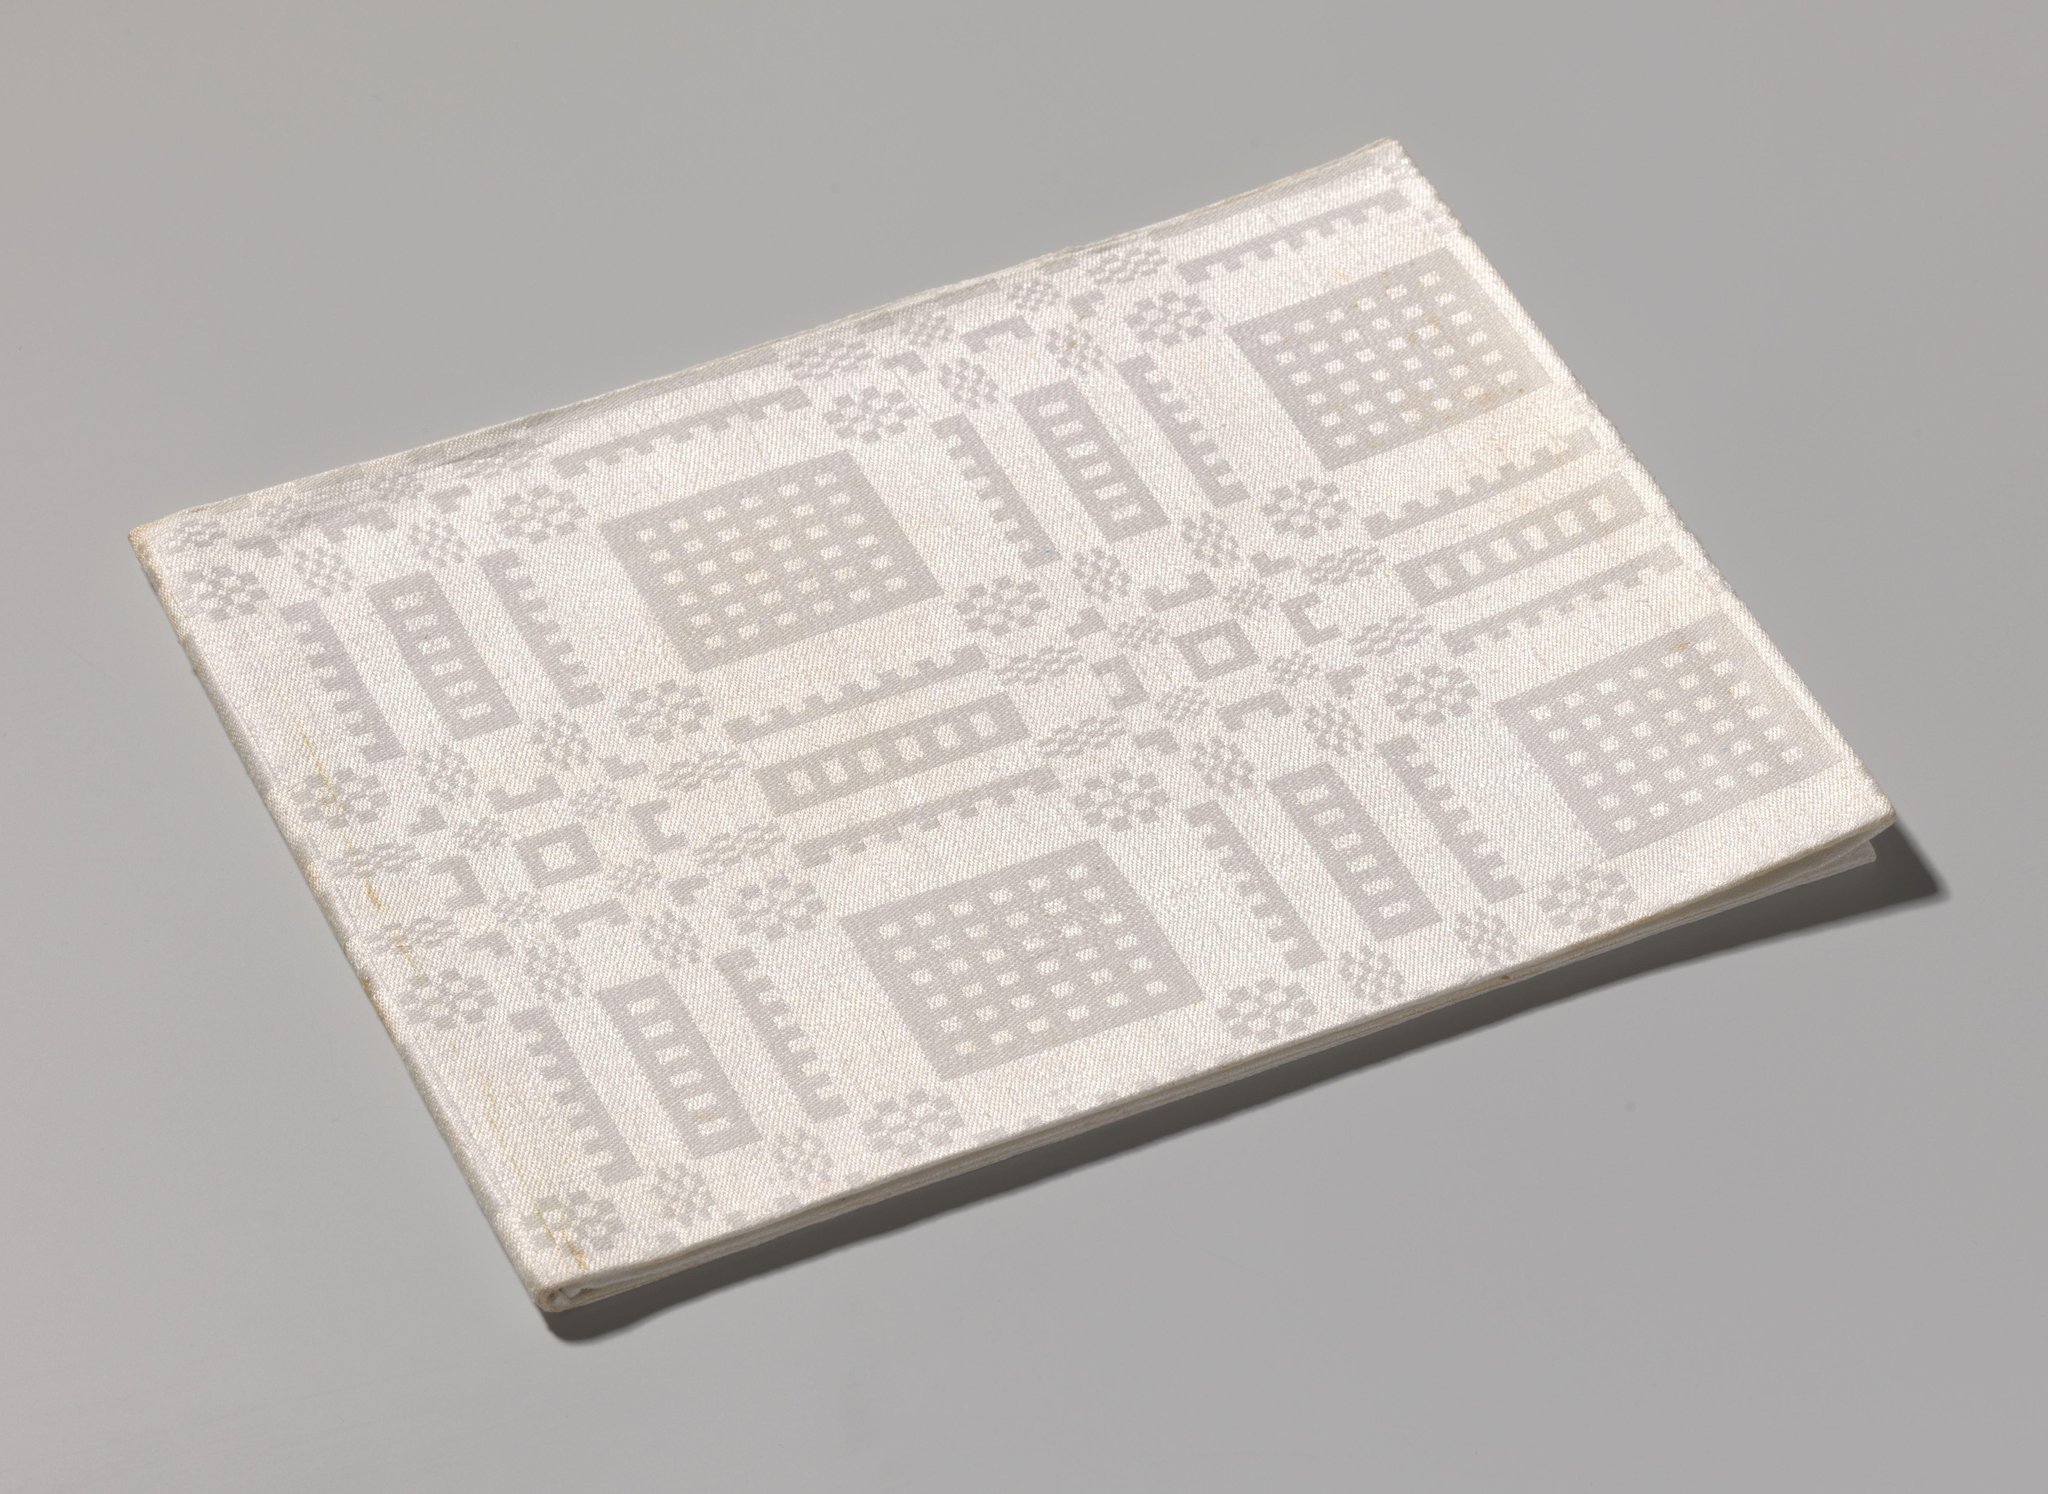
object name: napkin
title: Servet met pellenpatroon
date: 1756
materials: linen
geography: northern netherlands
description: Servet van wit linnen met pellenpatroon, merk kroon G 30 en 1756.